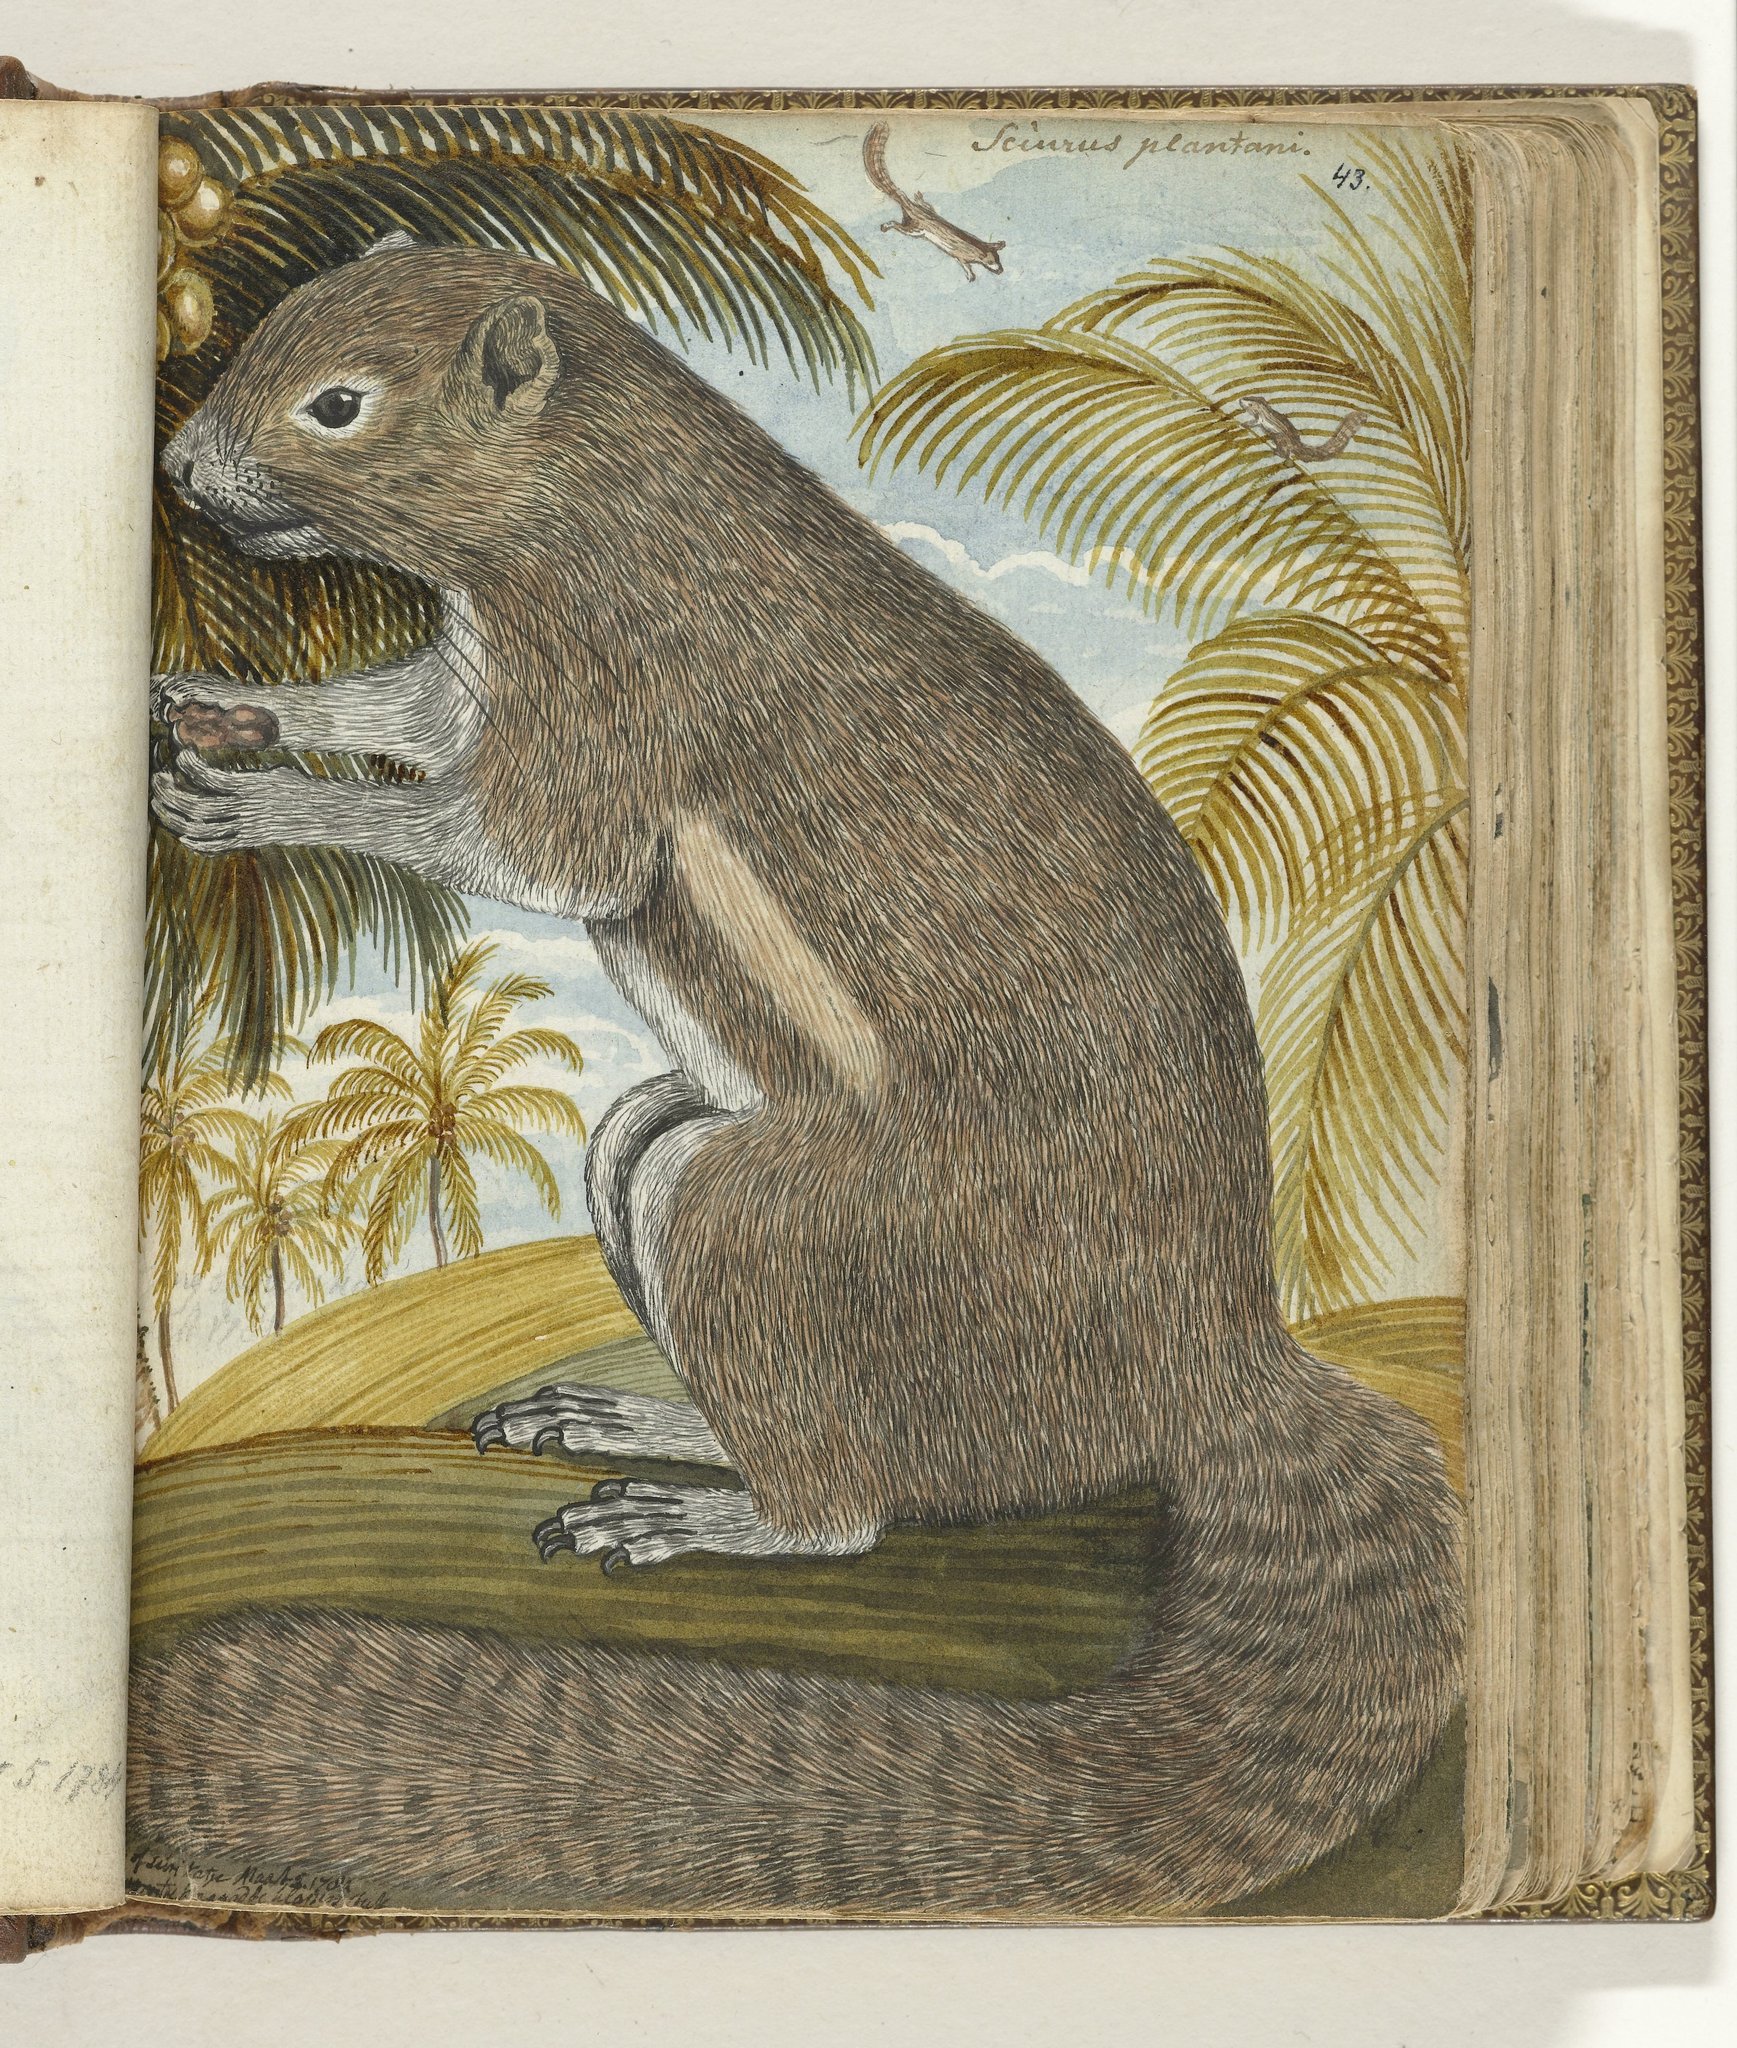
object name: drawing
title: Badjing of sirikatje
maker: jan brandes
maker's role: draughtsman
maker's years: 1743-1808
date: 1784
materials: paper, pencil, watercolor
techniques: brush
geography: jakarta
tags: rodents: squirrel, java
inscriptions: inscription: ‘Sciurus plantani’, inscription: ‘badging of surikatje Maart 5. 1784 OI eekhoorntje knaagde klappers stuk’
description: Kleurtekening van een Javaans eekhoorntje of klapperrat zittend op een palmtak tegen een achtergrond met klapperbomen en springende eekhoorns. Met opschrift. Onderdeel uit het schetsboek van Jan Brandes, dl. 1 (1808), p. 43.